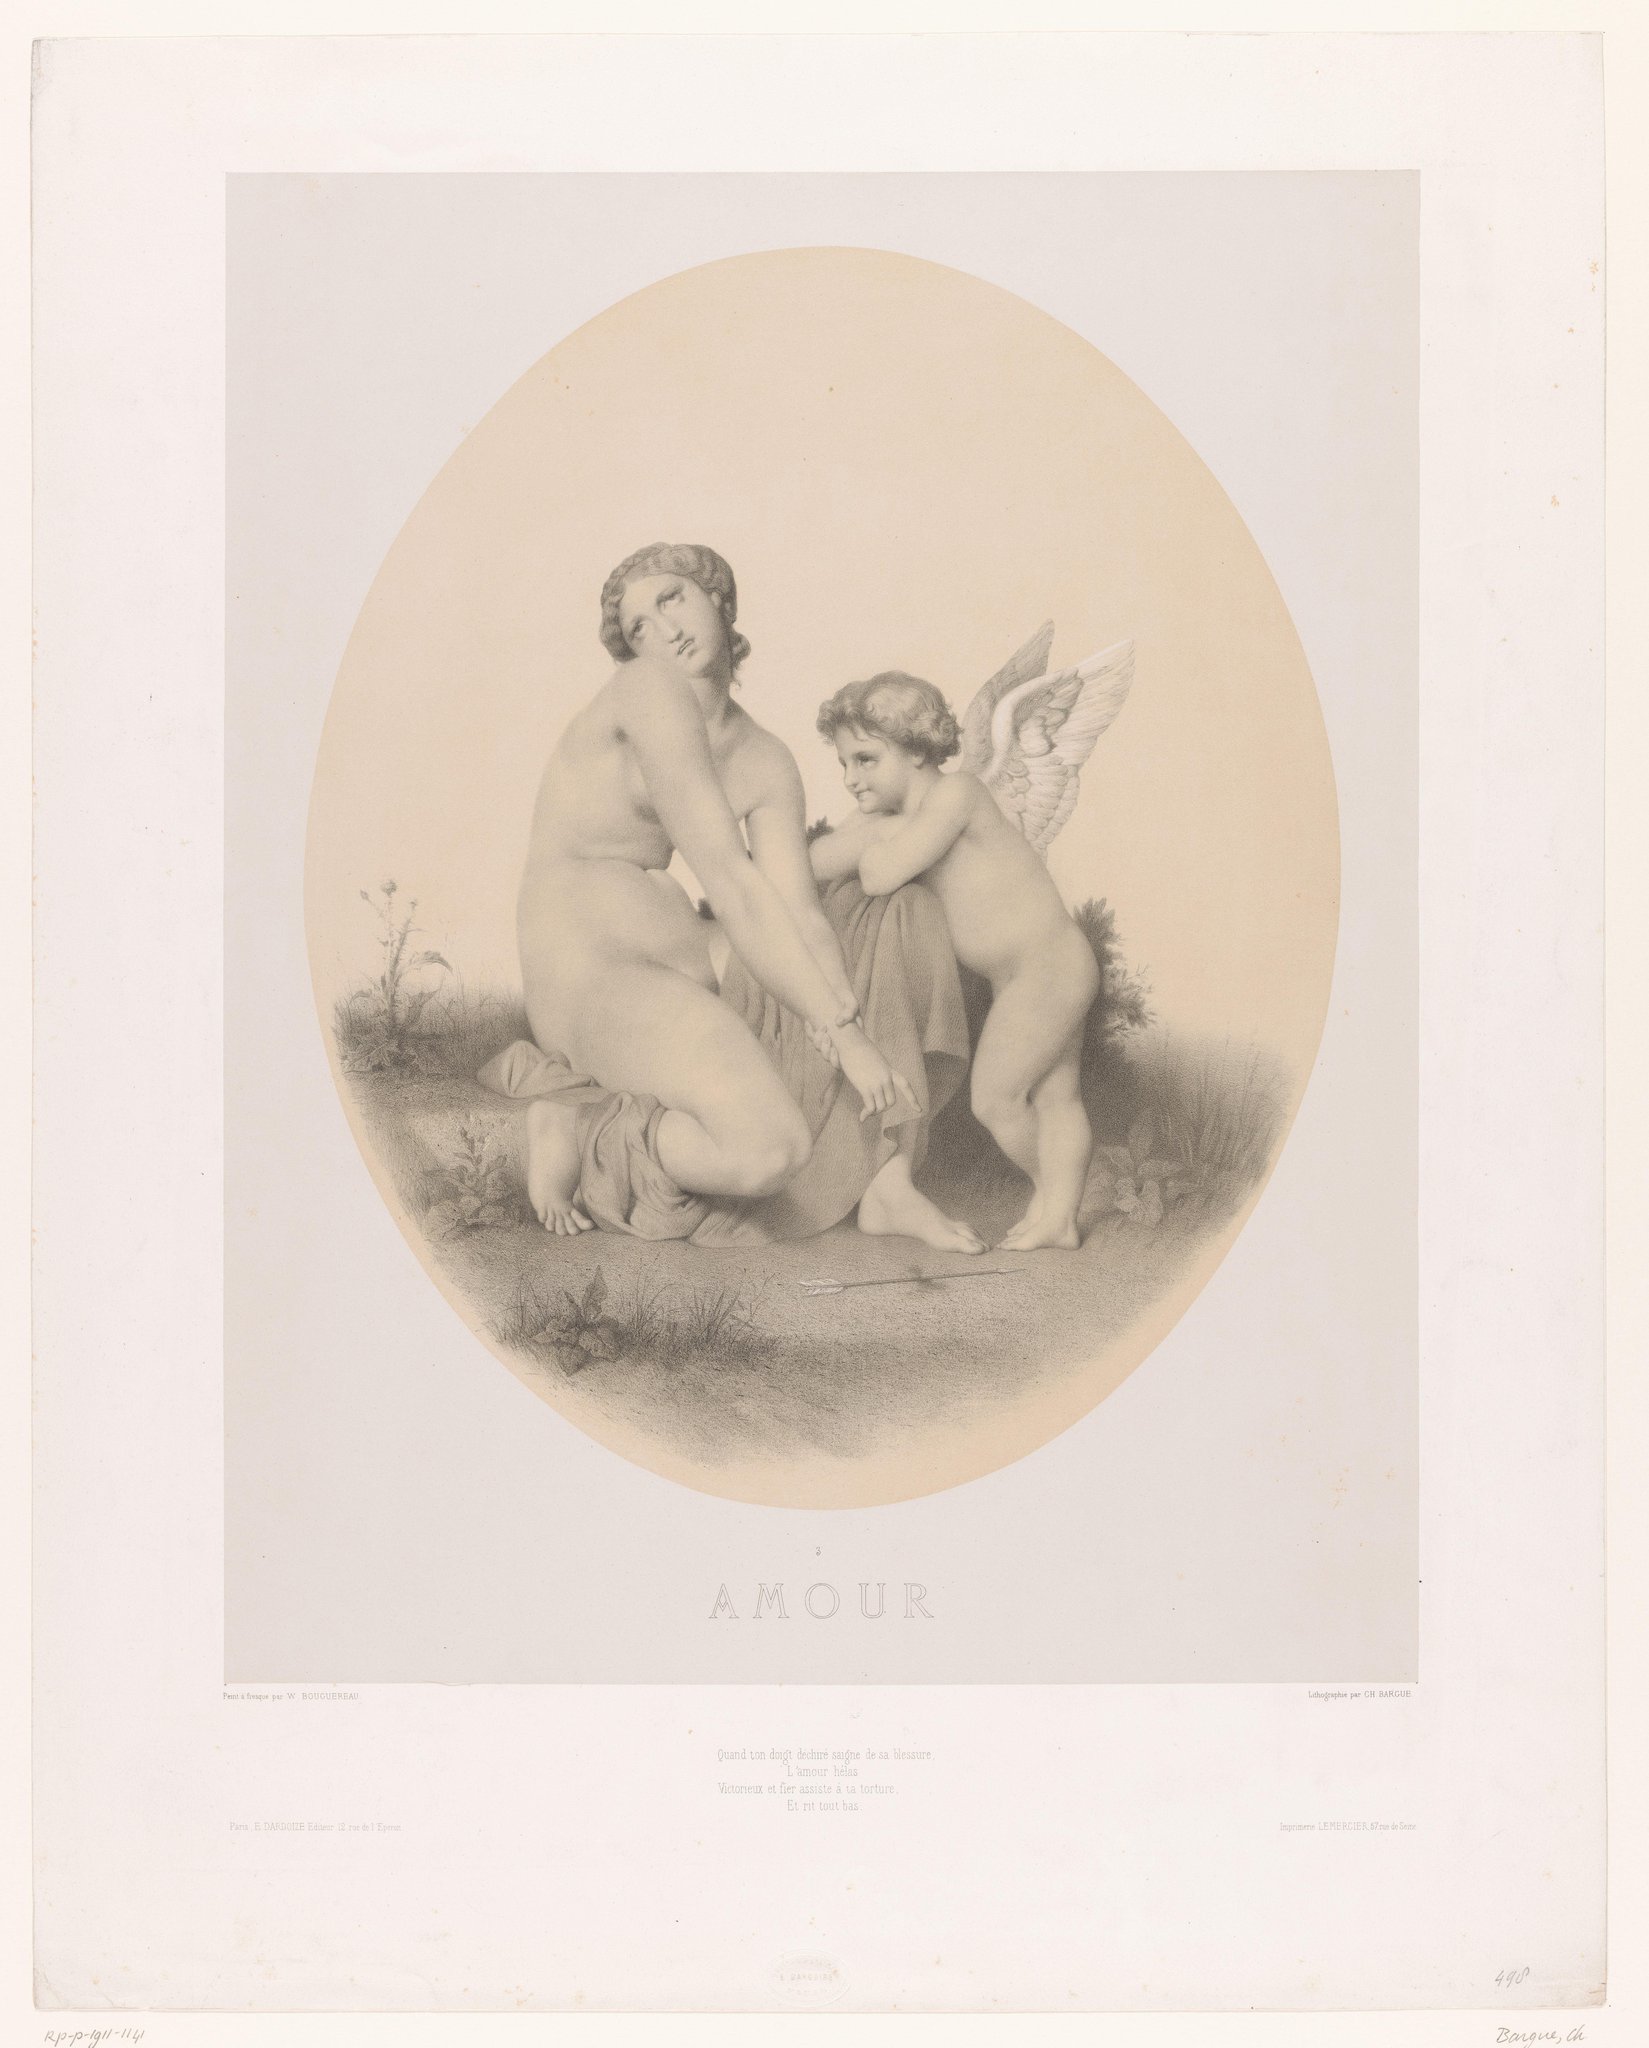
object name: print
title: Cupido heeft Venus verwond met zijn pijl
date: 1855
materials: paper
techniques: tone lithography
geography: paris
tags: cupid shooting a dart, venus and cupid (cupid not being mere attribute)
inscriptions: collector's mark: Lugt 2228a, check stamp: Lugt 652g